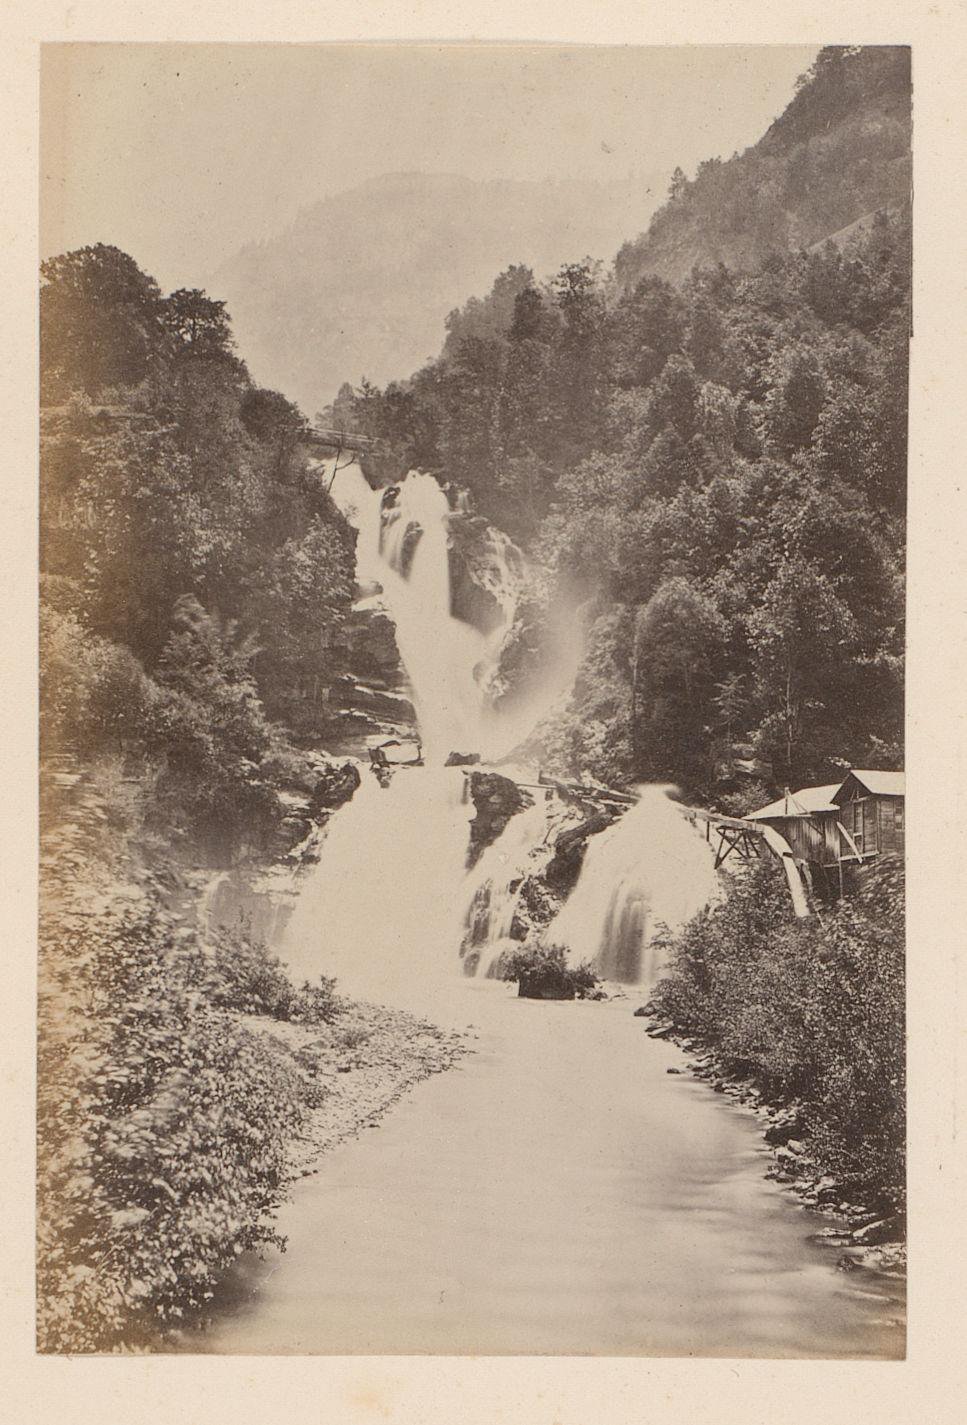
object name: album leaf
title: Gezicht op de Reichenbachwaterval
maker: Anonymous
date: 1860-1890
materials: paper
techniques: albumen print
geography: reichenbach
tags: waterfall